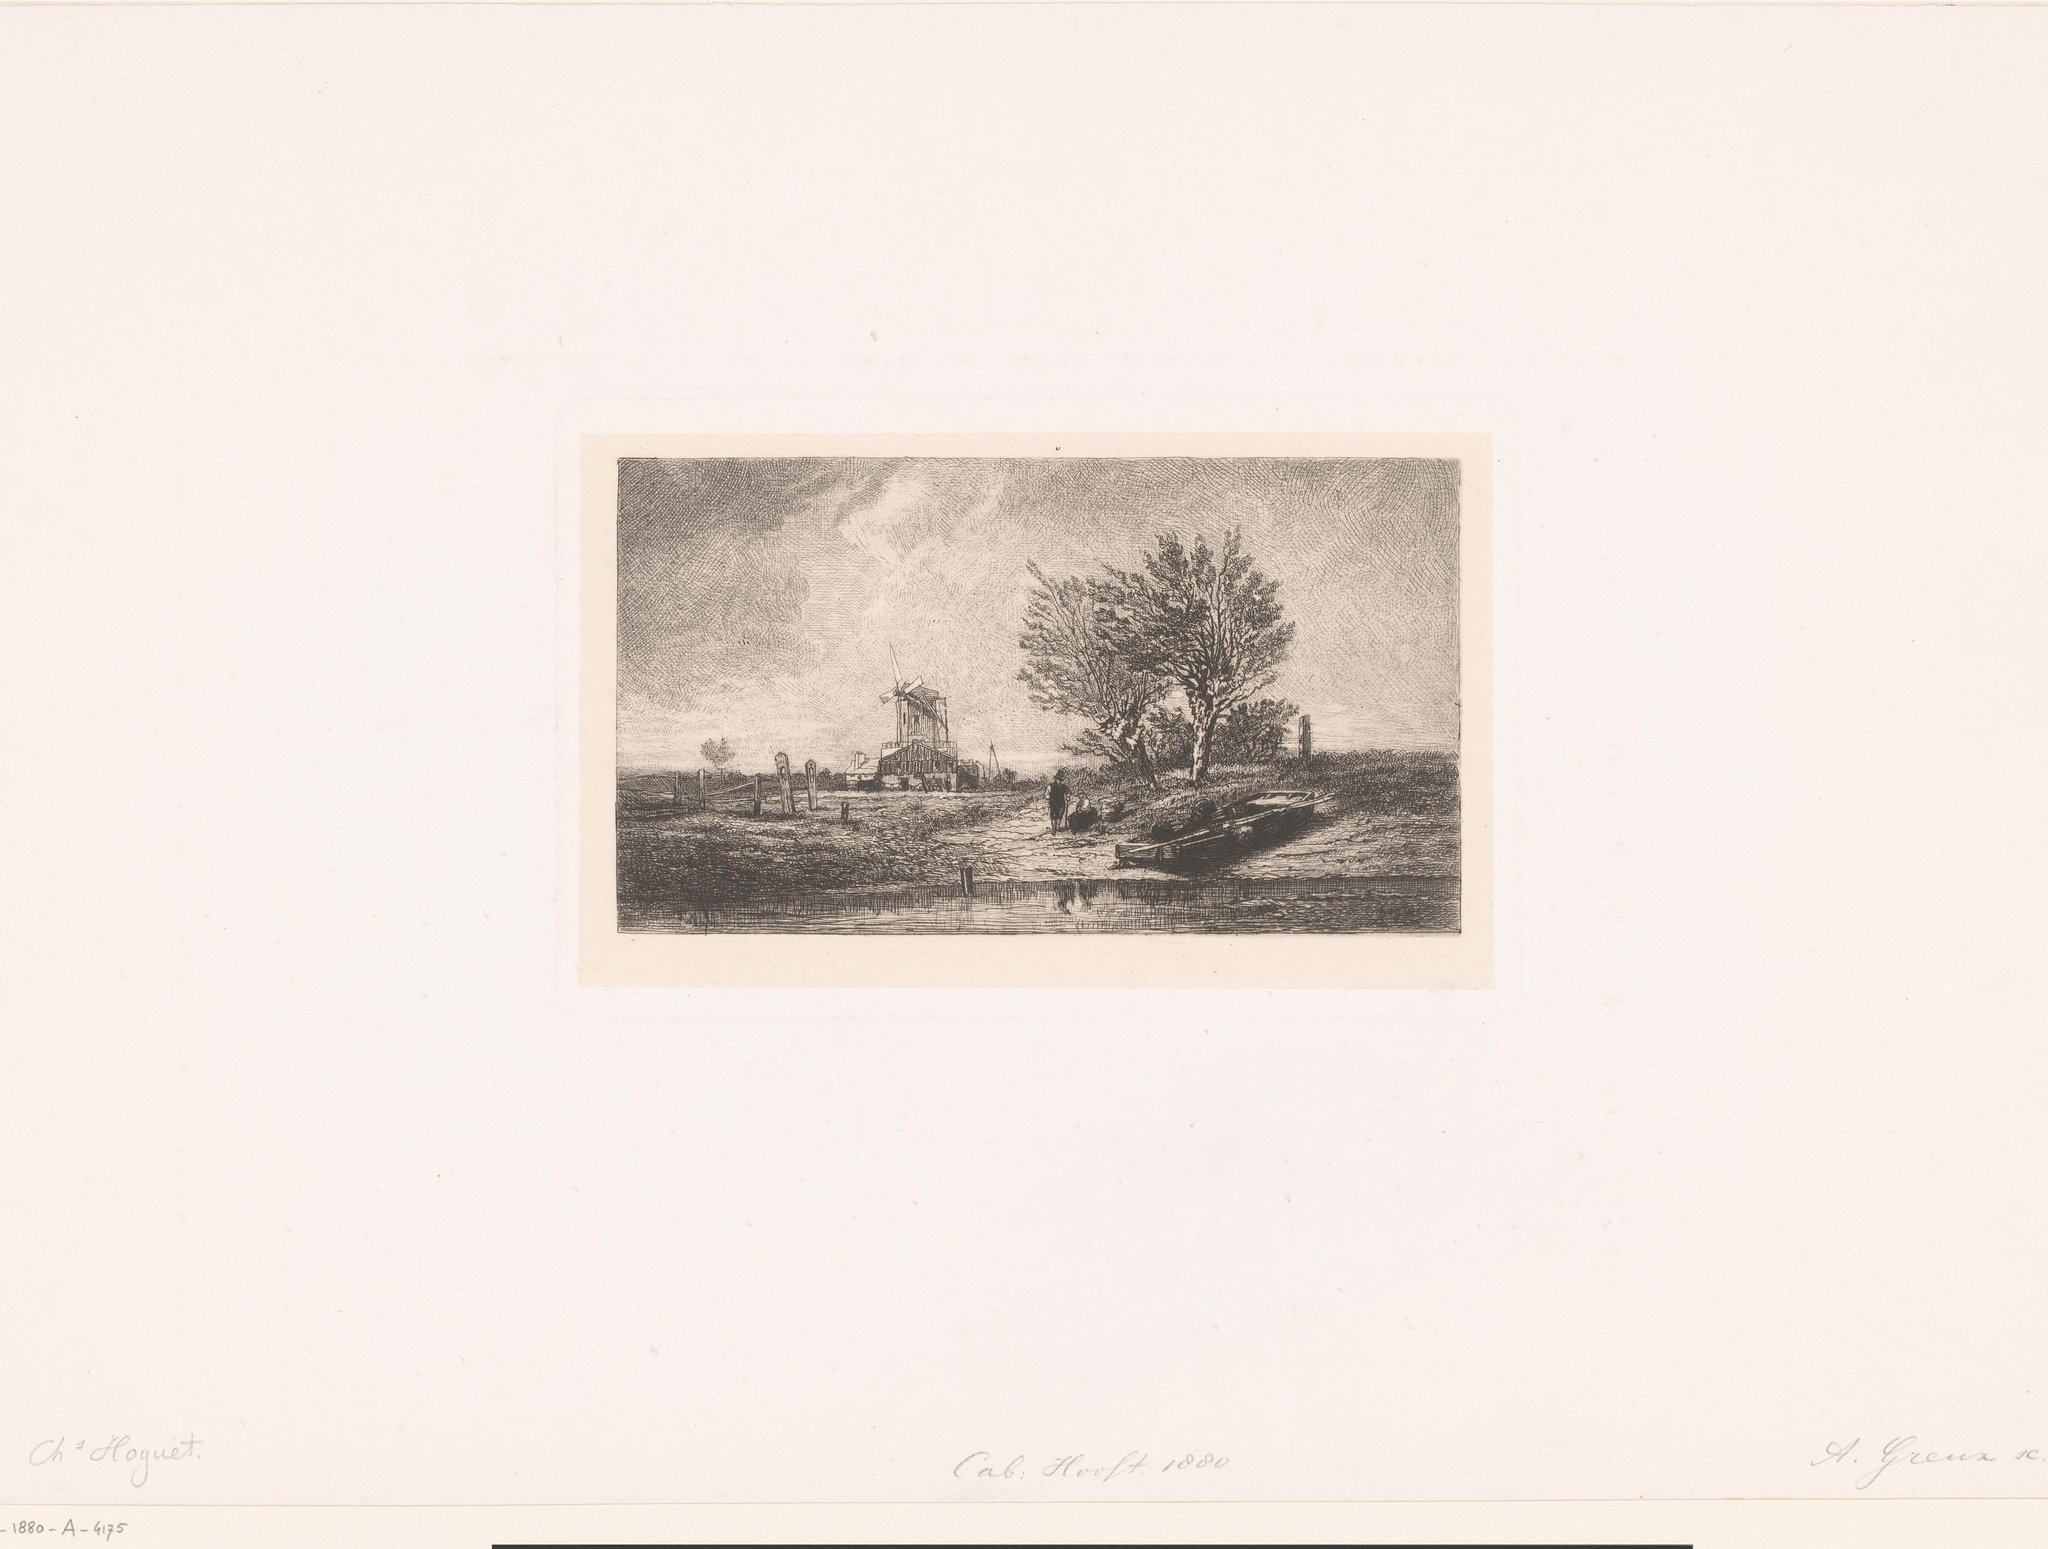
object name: print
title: Twee figuren in een rivierlandschap met molen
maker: amédée paul greux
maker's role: print maker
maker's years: 1836-1919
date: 1863-1880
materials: paper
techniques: etching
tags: windmill in landscape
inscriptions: collector's mark: Lugt 2228